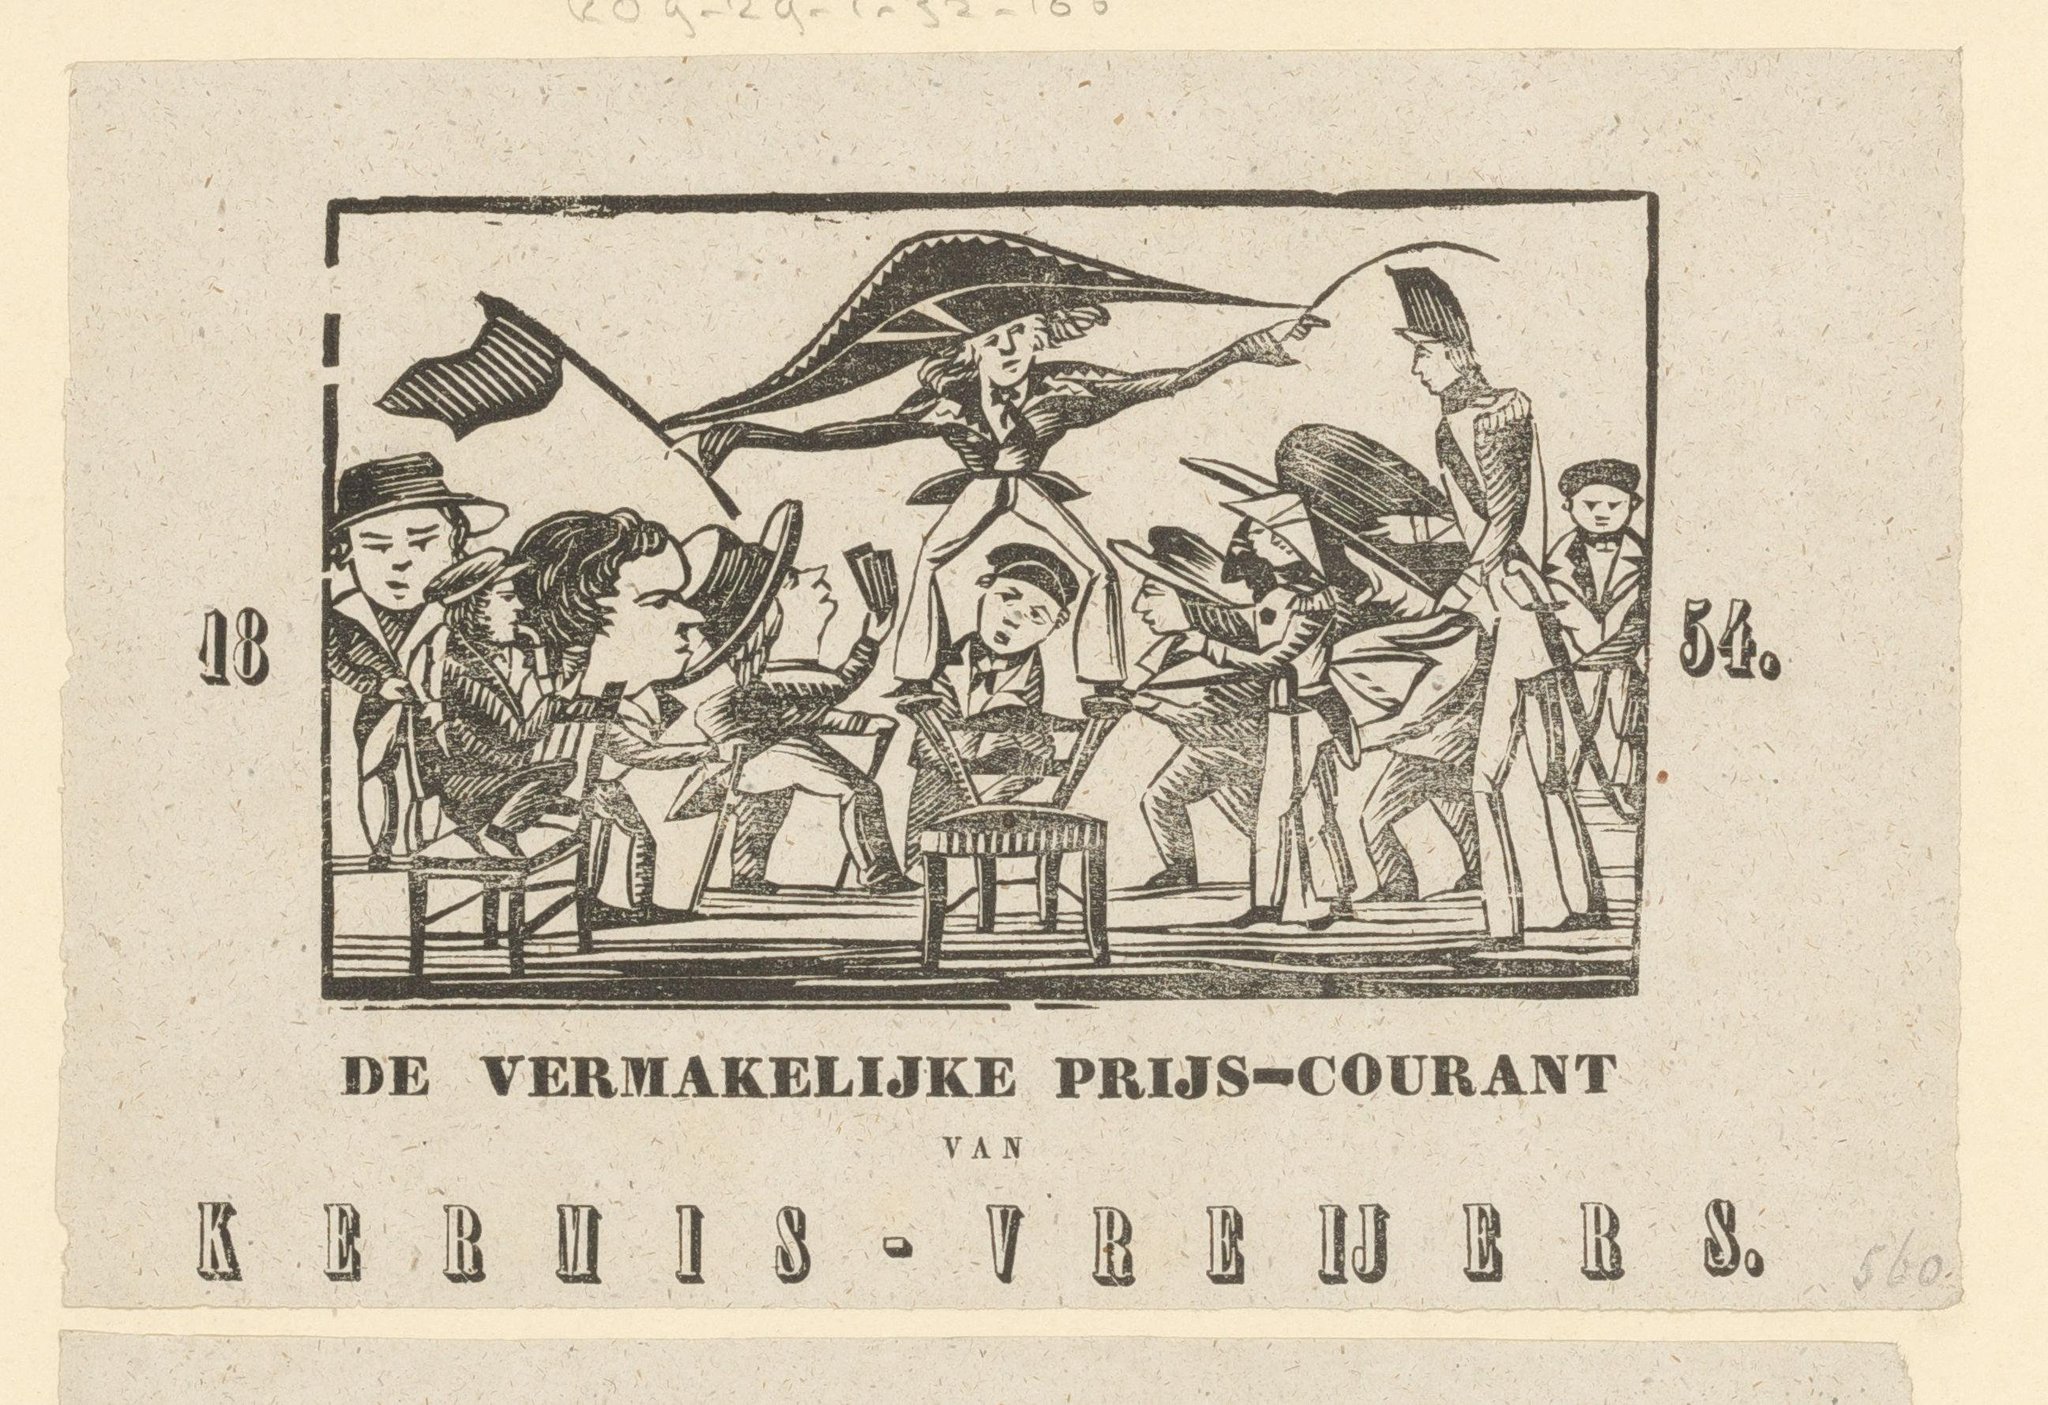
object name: print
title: De vermakelijke Prijs-Courant van Kermis-Vrijers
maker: Anonymous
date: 1854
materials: paper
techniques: letterpress printing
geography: amsterdam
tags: one-sided courting; pursuit; difficult choice, pleasure fair and circus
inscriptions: collector's mark, collector's mark: Lugt 1641